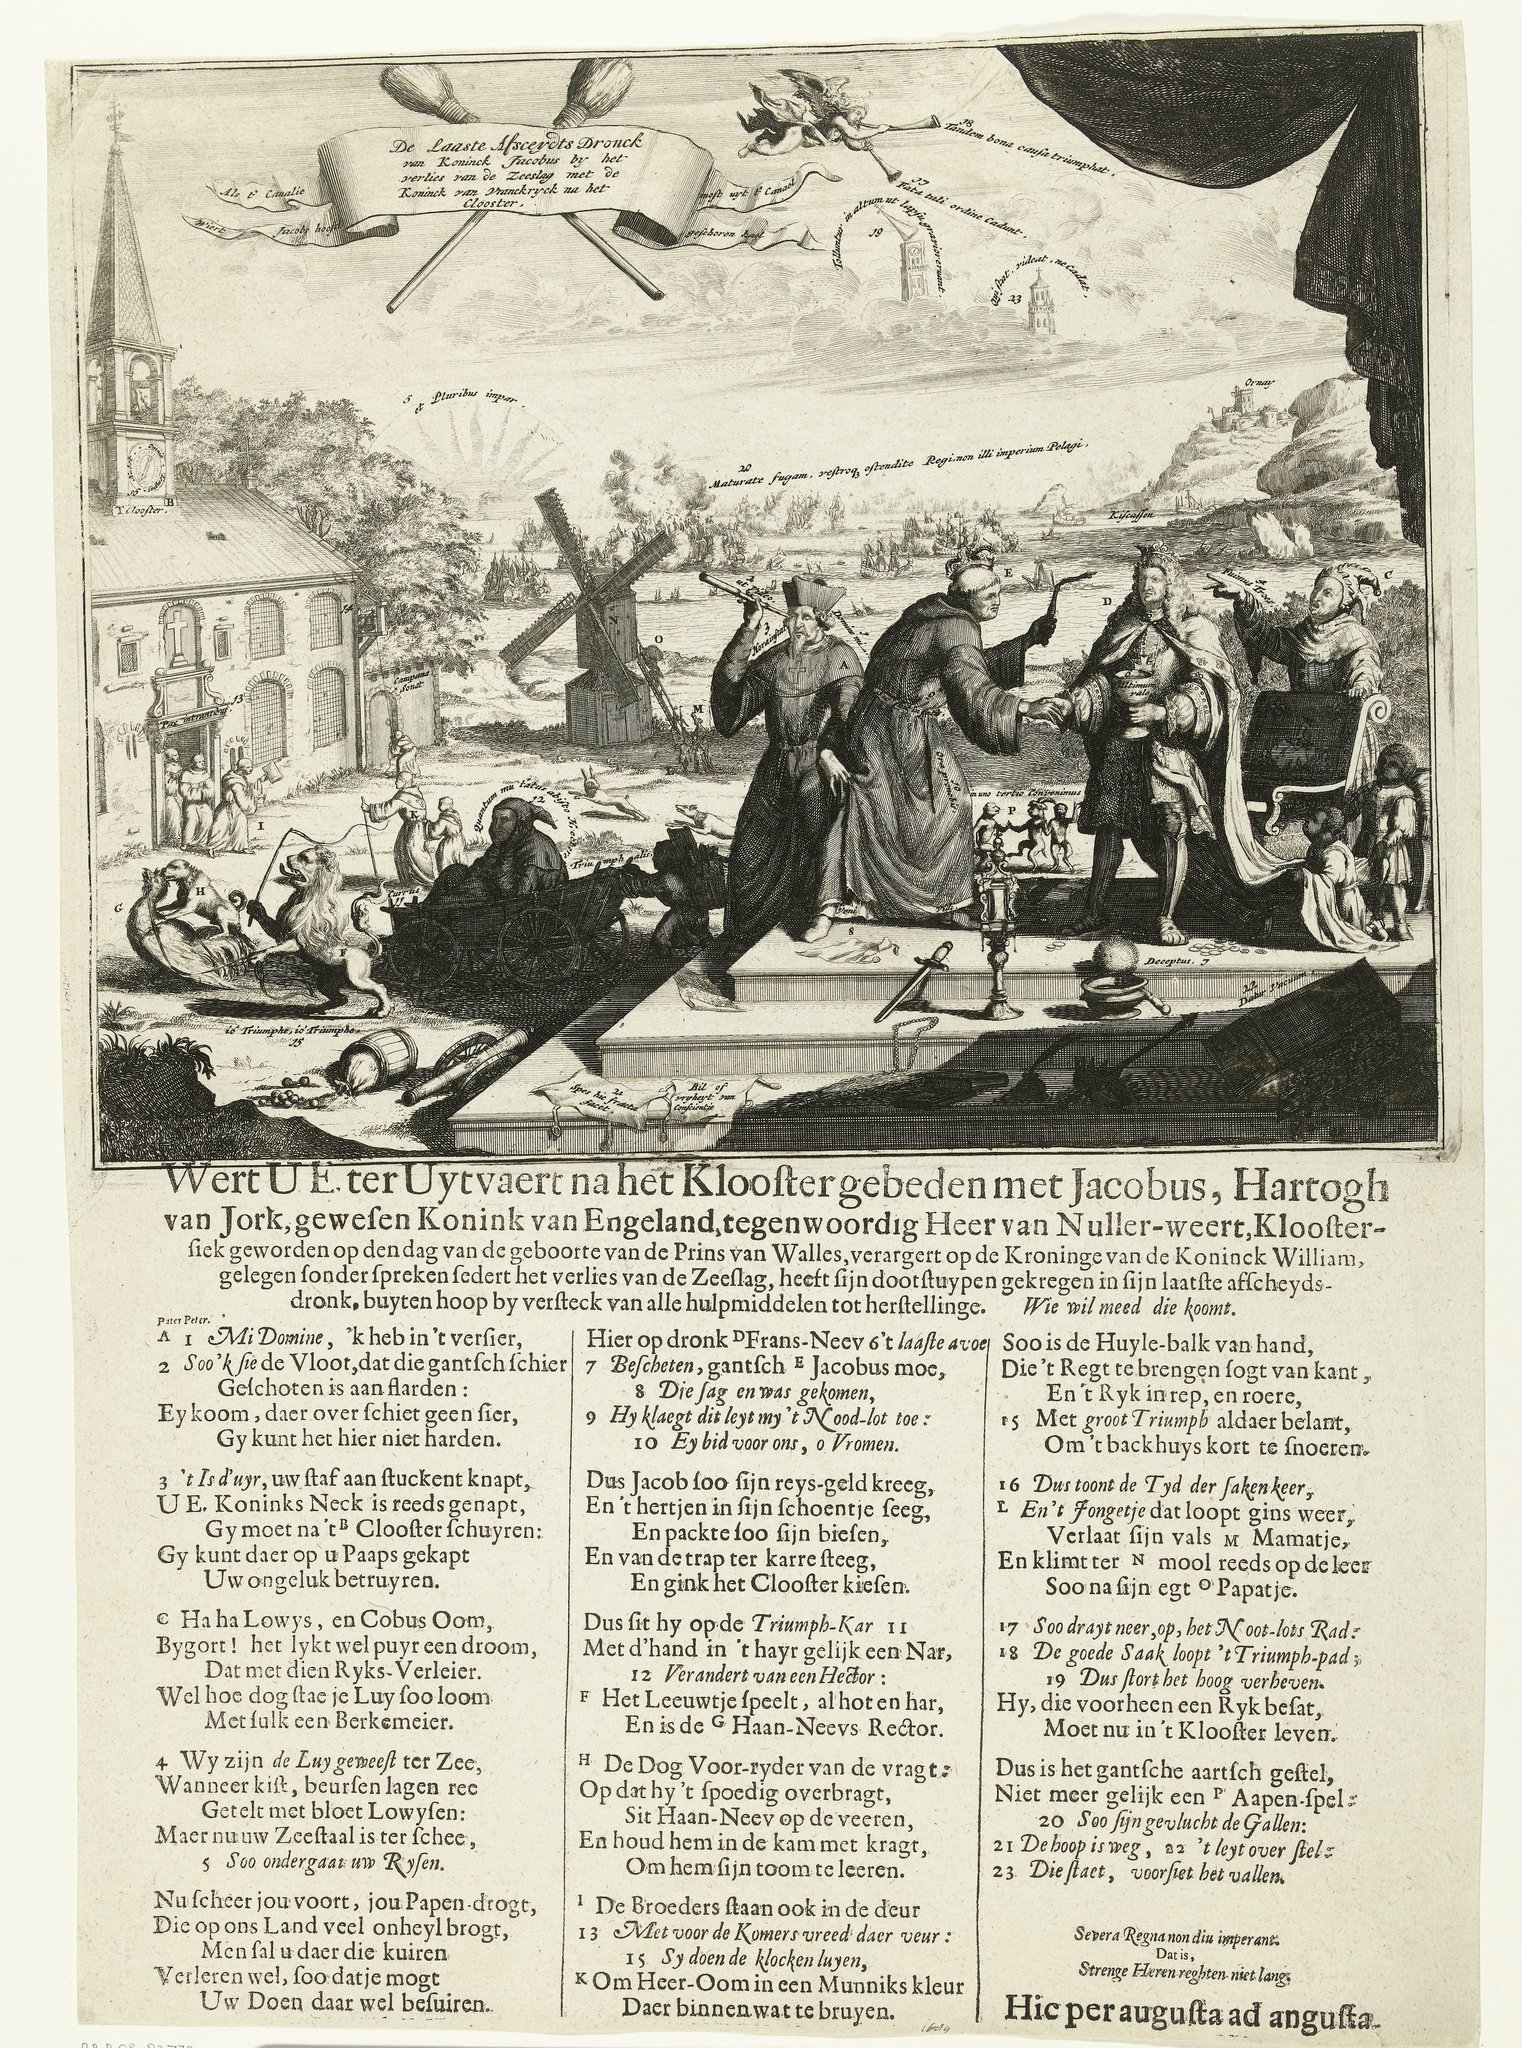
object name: cartoon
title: Wert U.E. ter Uytvaert na het Klooster gebeden met Jacobus, Hartogh van Jork, gewesen Konink van Engeland (...)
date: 1692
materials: paper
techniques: engraving, etching, letterpress printing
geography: northern netherlands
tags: jacobus ii (koning van engeland en schotland), lodewijk xiv (koning van frankrijk), entering a convent, political caricatures and satires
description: Spotprent op de Engelse koning Jacobus II na de overwinning van de Hollanders en Engelsen op de Fransen in de slag bij Kaap la Hogue in het Kanaal, 29 mei t/m 3 juni 1692, en op zijn voornemen het klooster in te gaan. Jacobus als een monnik met gebroken kroon en geknakte scepter neemt afscheid van koning Lodewijk XIV met een afscheidsdronk. Achter de koning en jezuïet met een verrekijker. Links het klooster, verder een windmolen, een monnik in een kar getrokken door de Franse Haan, dansende aapjes, etc. Op de achtergrond de zeeslag. Op het blad onder de plaat een onderschrift in drie kolommen.